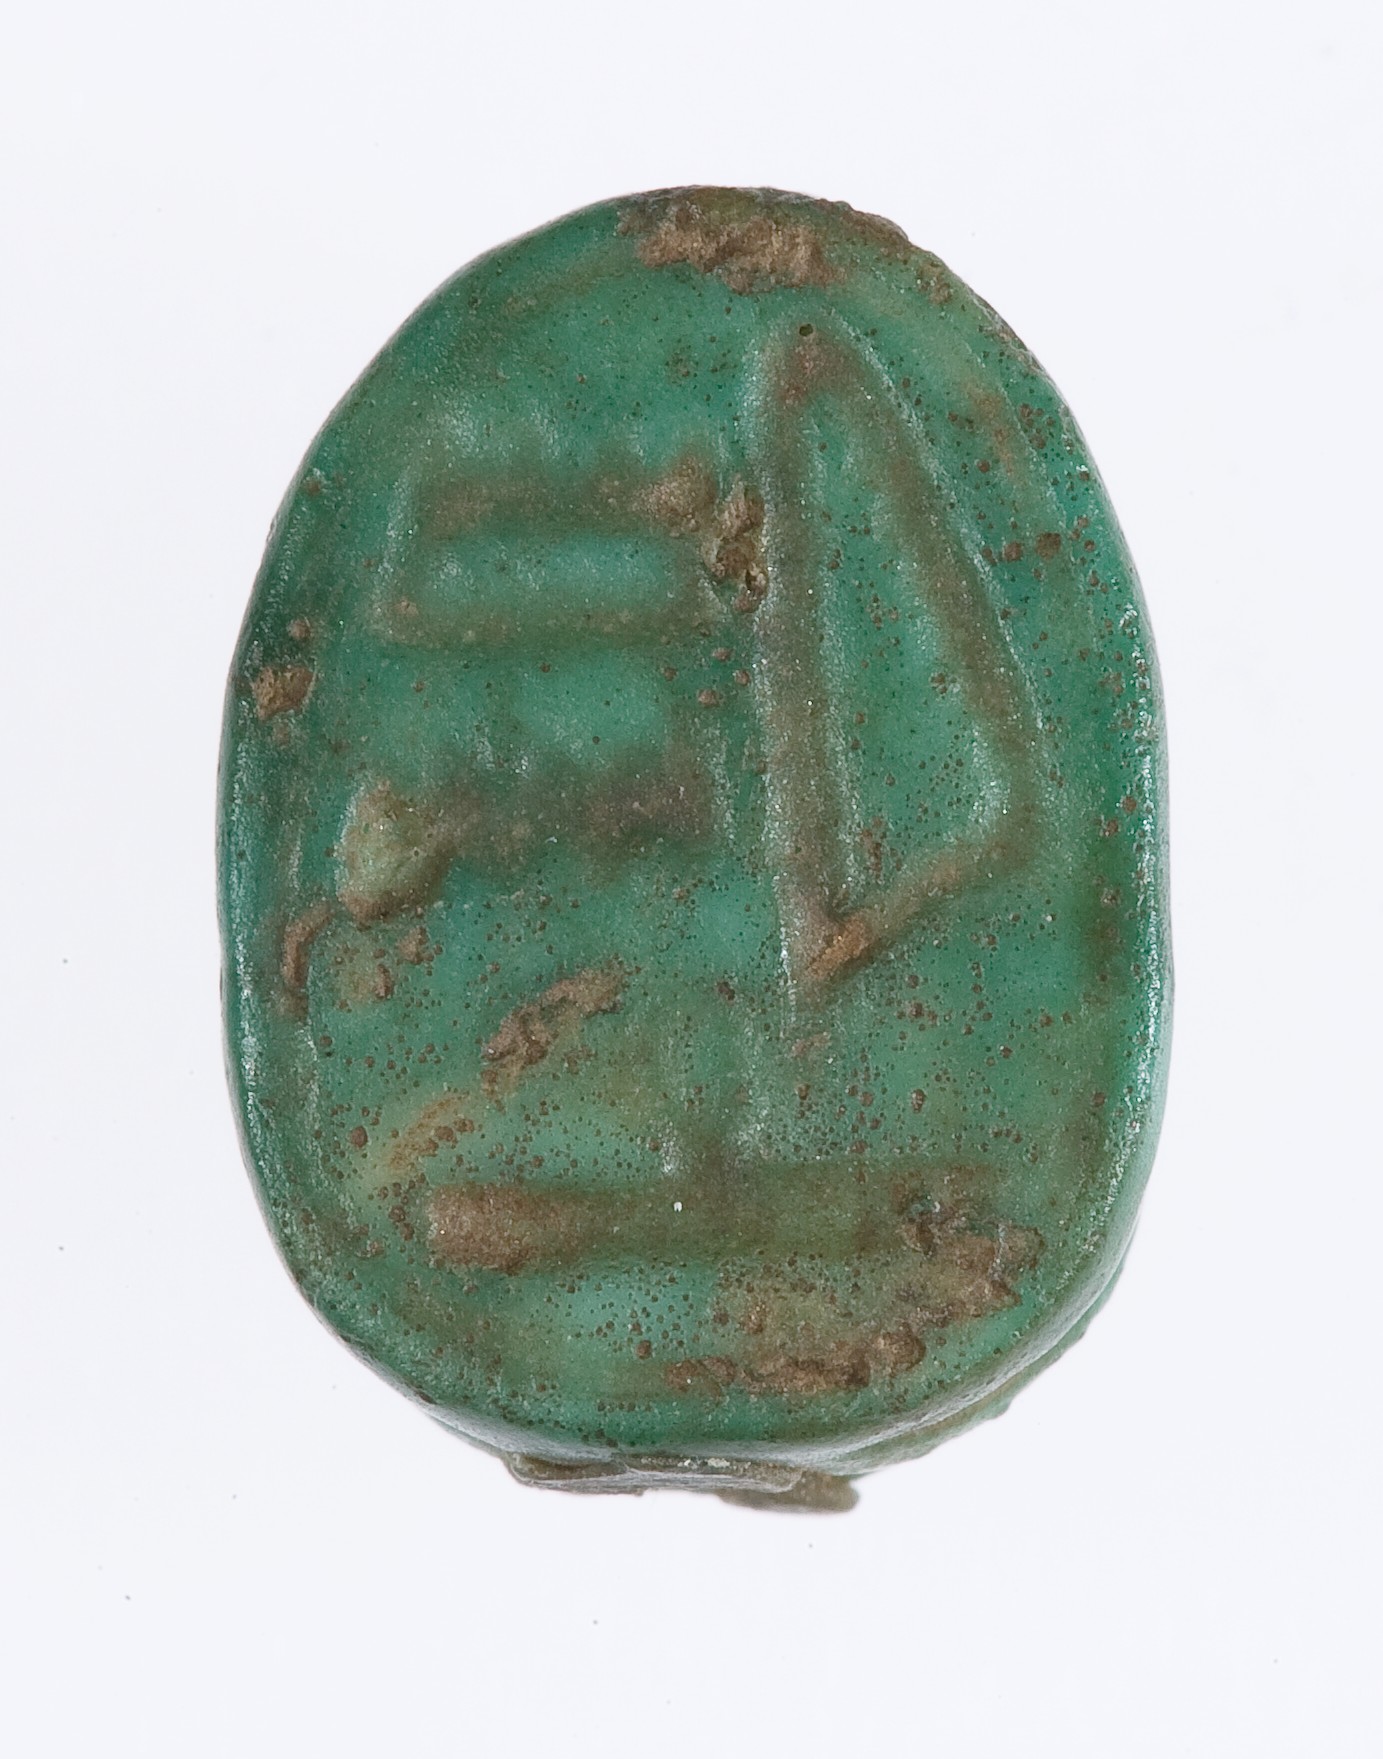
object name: scarab, amenhotep i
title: Scarab Inscribed With the Name Amenhotep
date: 1550-1458 BCE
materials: stone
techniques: glazing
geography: egypt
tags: scarabs